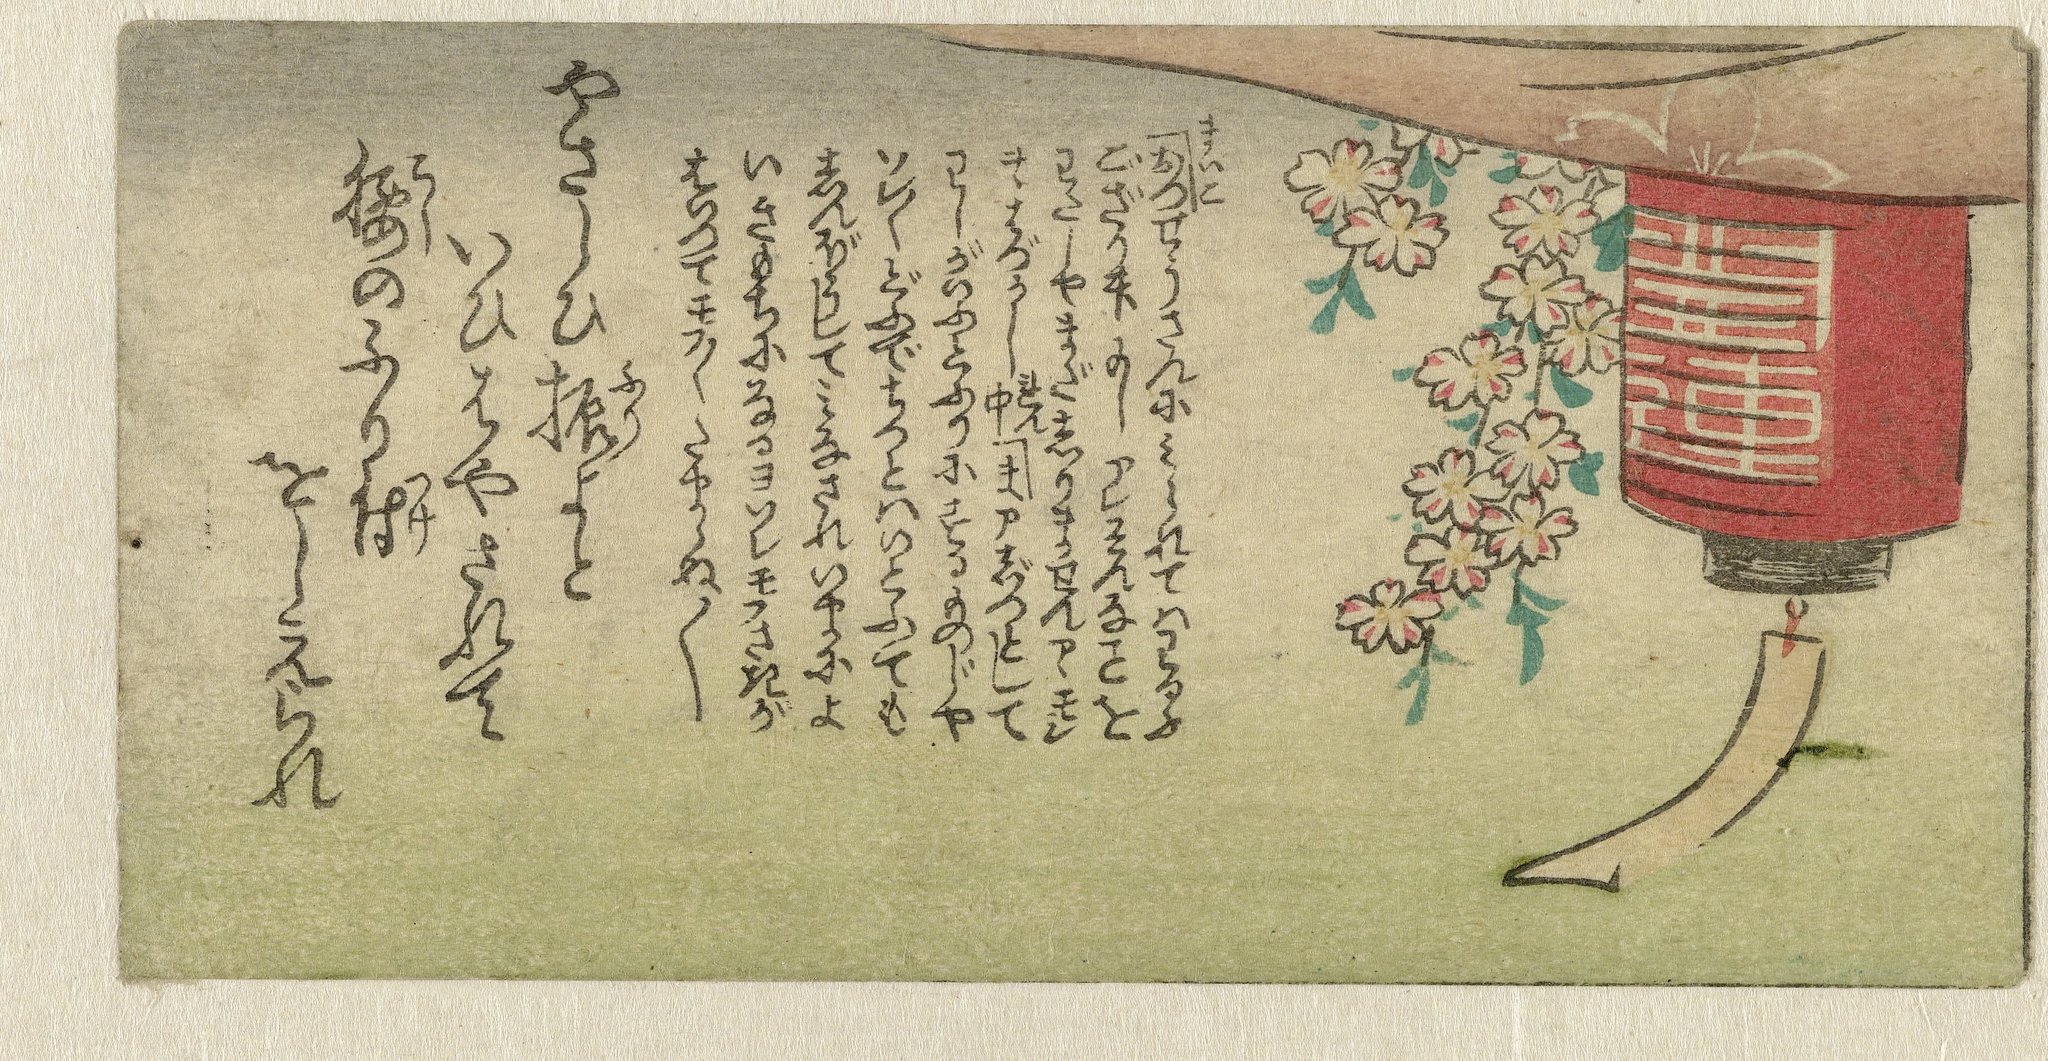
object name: print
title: Waaierserie met begeleidende prenten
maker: Anonymous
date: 1850-1860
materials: paper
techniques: woodcut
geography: japan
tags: lantern, oriental ideographic script (chinese, korean, japanese)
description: Een rode lampion en bloesem, met een begleidende tekst bij de 'danserswaaier'.